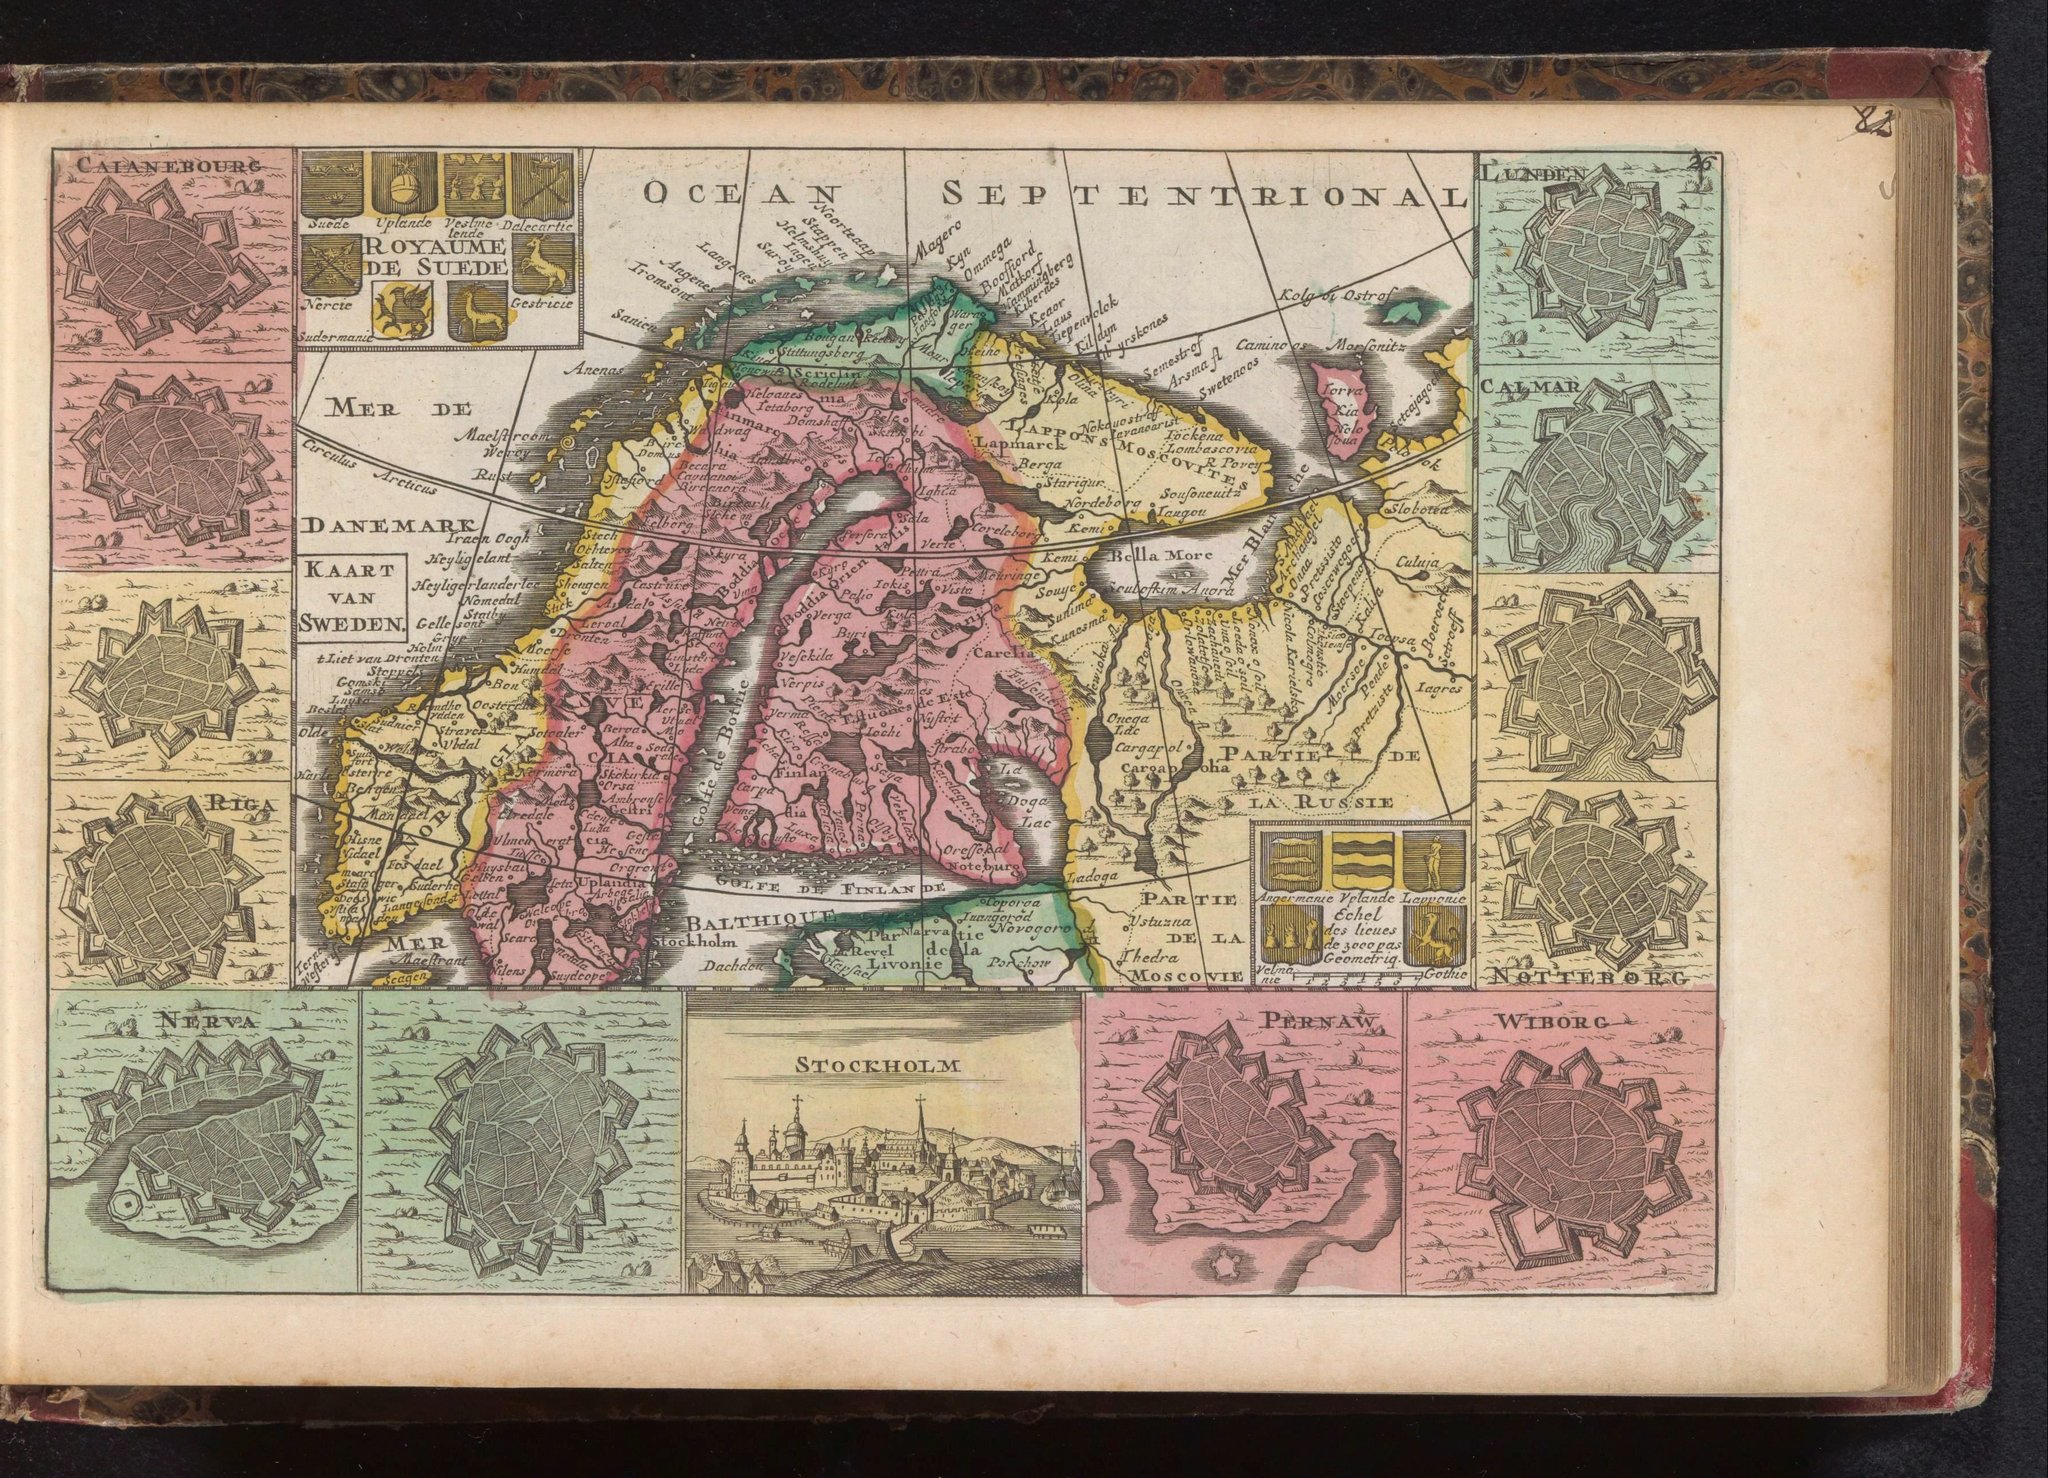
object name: print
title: Kaart van Sweden / Royaume de Suede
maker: Anonymous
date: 1700-1706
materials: paper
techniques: engraving, etching, hand coloring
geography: amsterdam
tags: maps of separate countries or regions, norway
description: Kaart van het koninkrijk Zweden, aan weerszijden twaalf plattegronden van vestingsteden en een gezicht op Stockholm. Ook met Noorwegen en het huidige Finland. Onderdeel van een atlas met 223 kaarten van landen en steden en oorlogstaferelen in Europa in de periode ca. 1690-1735.